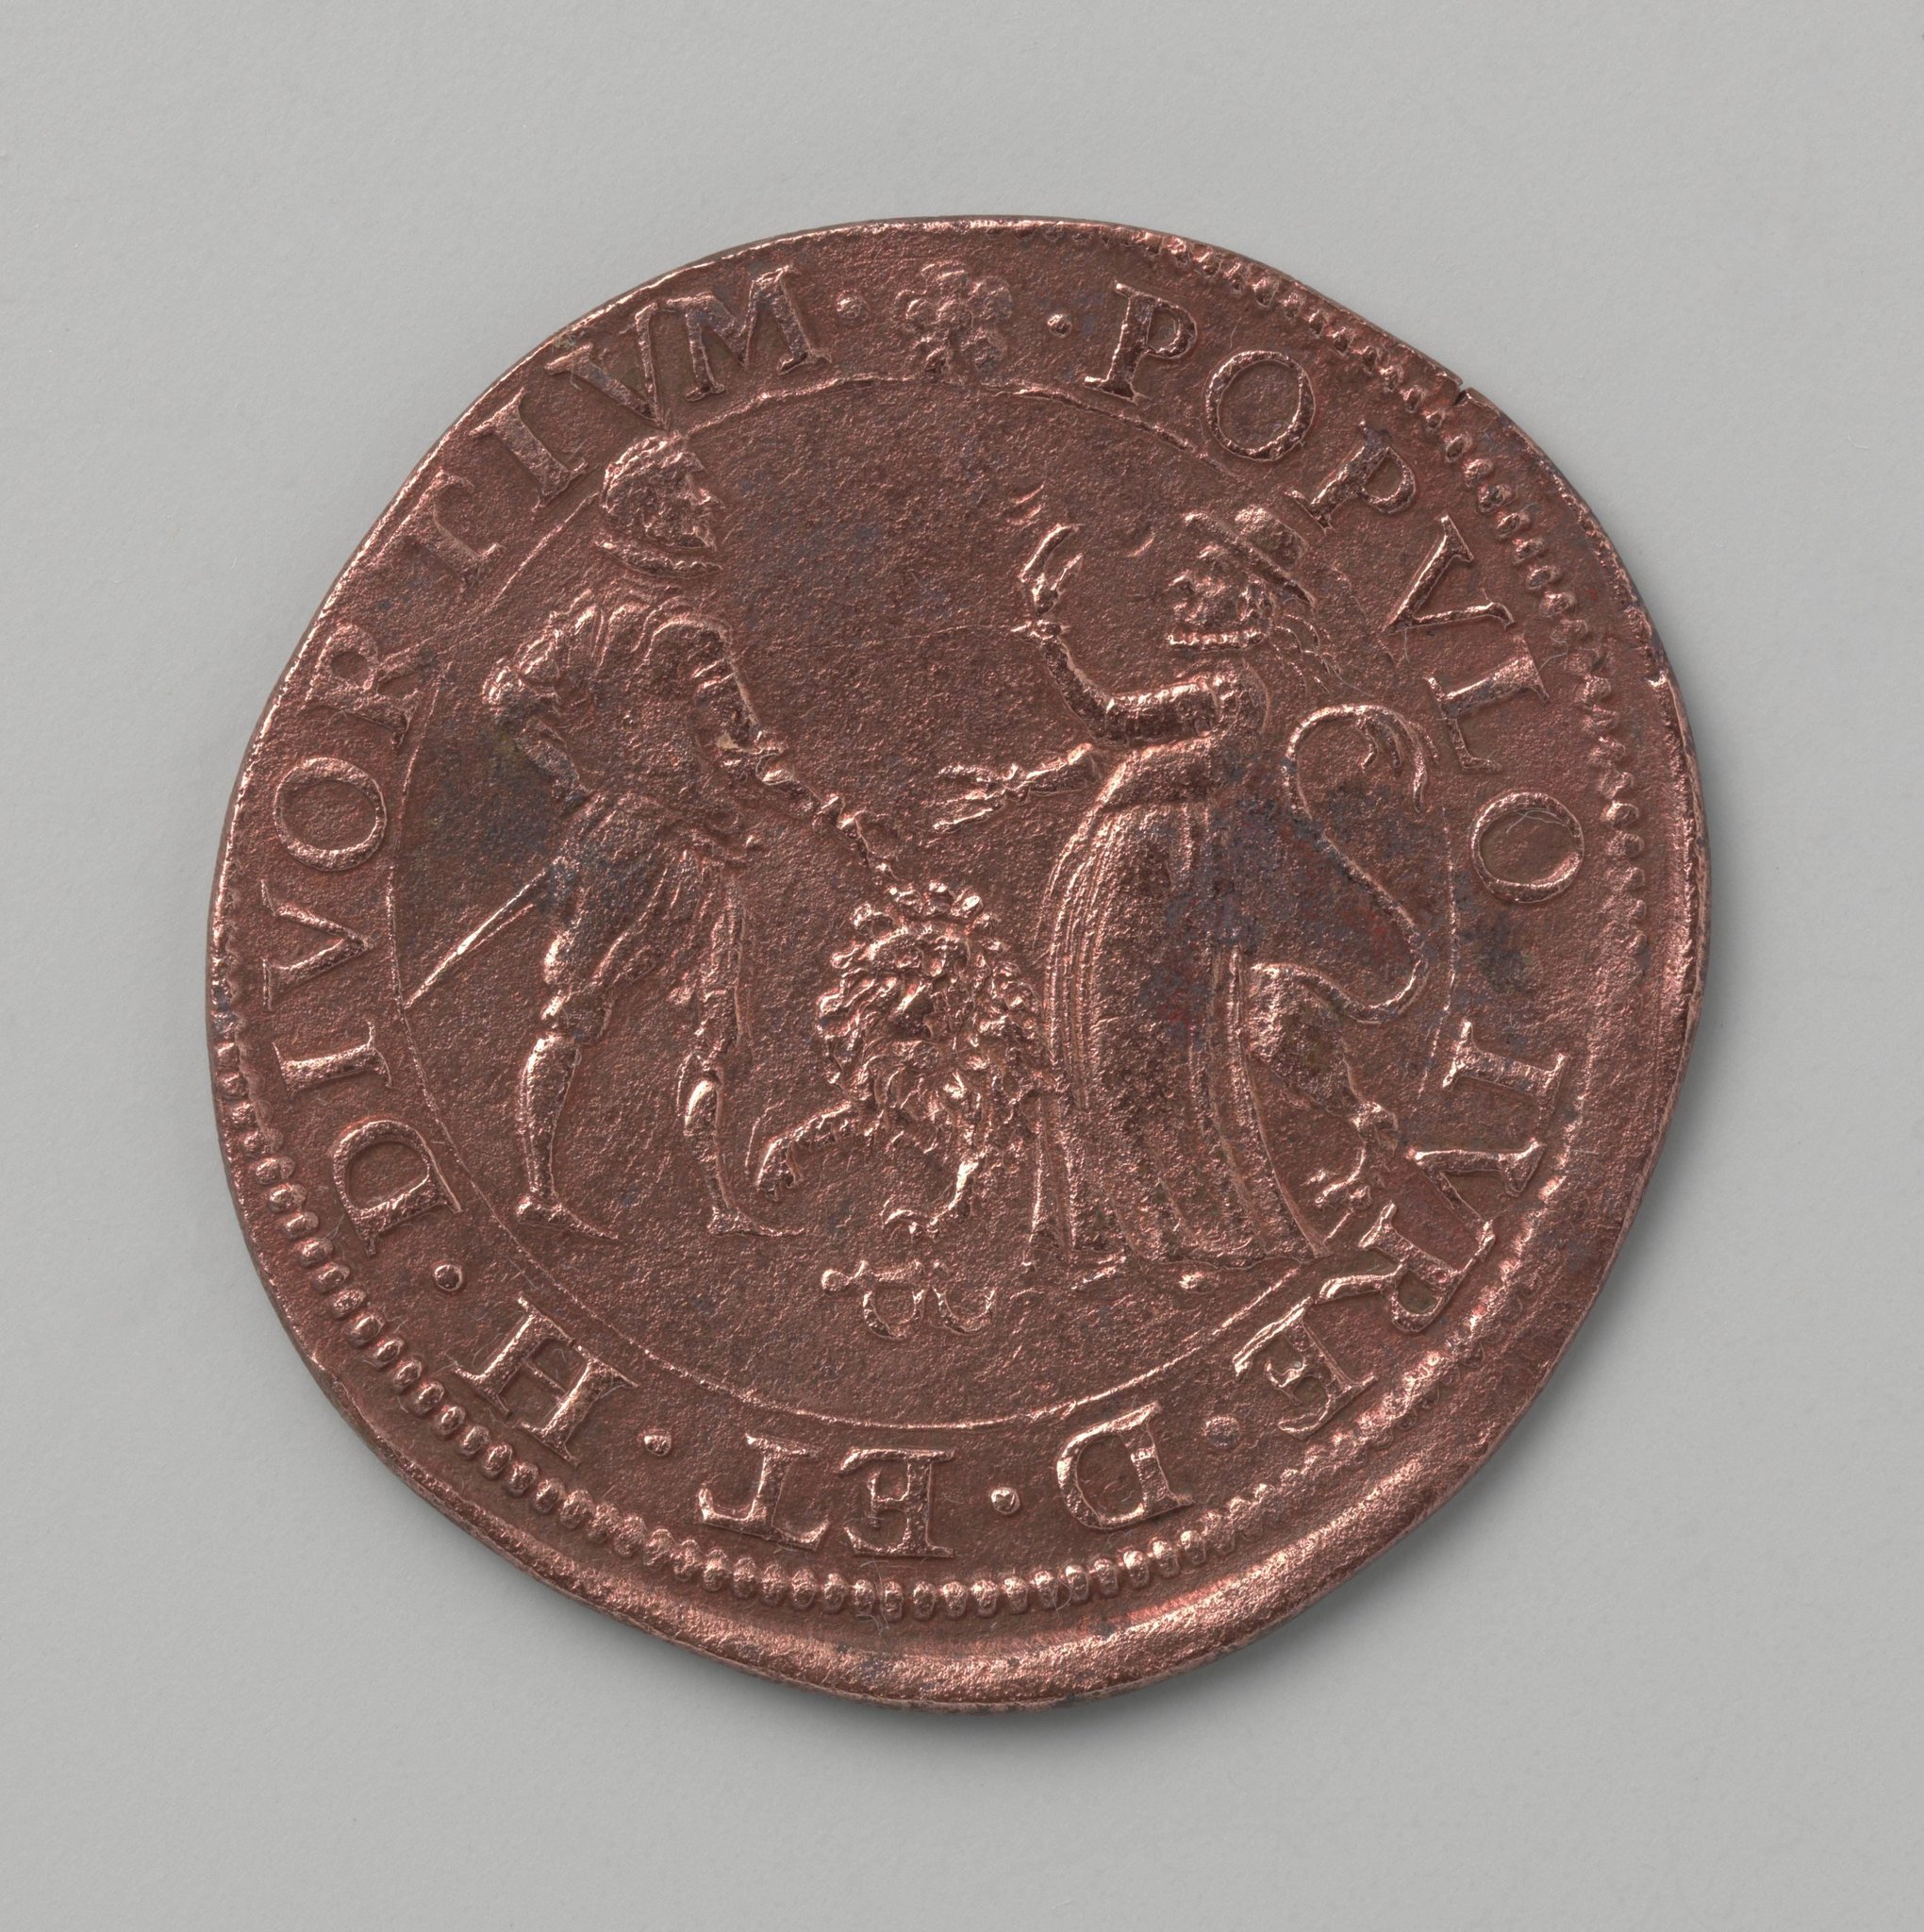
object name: jeton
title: The Renunciation of Philip II by the Netherlands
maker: gerard van bylaer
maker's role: die cutter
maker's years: 1540-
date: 1583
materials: copper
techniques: striking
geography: dordrecht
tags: philip ii of spain, delft, william i (prince of orange), netherlands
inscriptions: circumscription: ‘POPVLO IVRE D ET H DIVORTIVM’, circumscription: ‘VBI REX IN POPVLVM TIRANNVS 1583’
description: Commemorating Dutch liberty. Many medals were made to commemorate important events or people. The Dutch revolt against the Spanish king that began in 1568 and the ups and downs of the independent Dutch Republic, which existed from 1588, were ample reasons for striking medals.